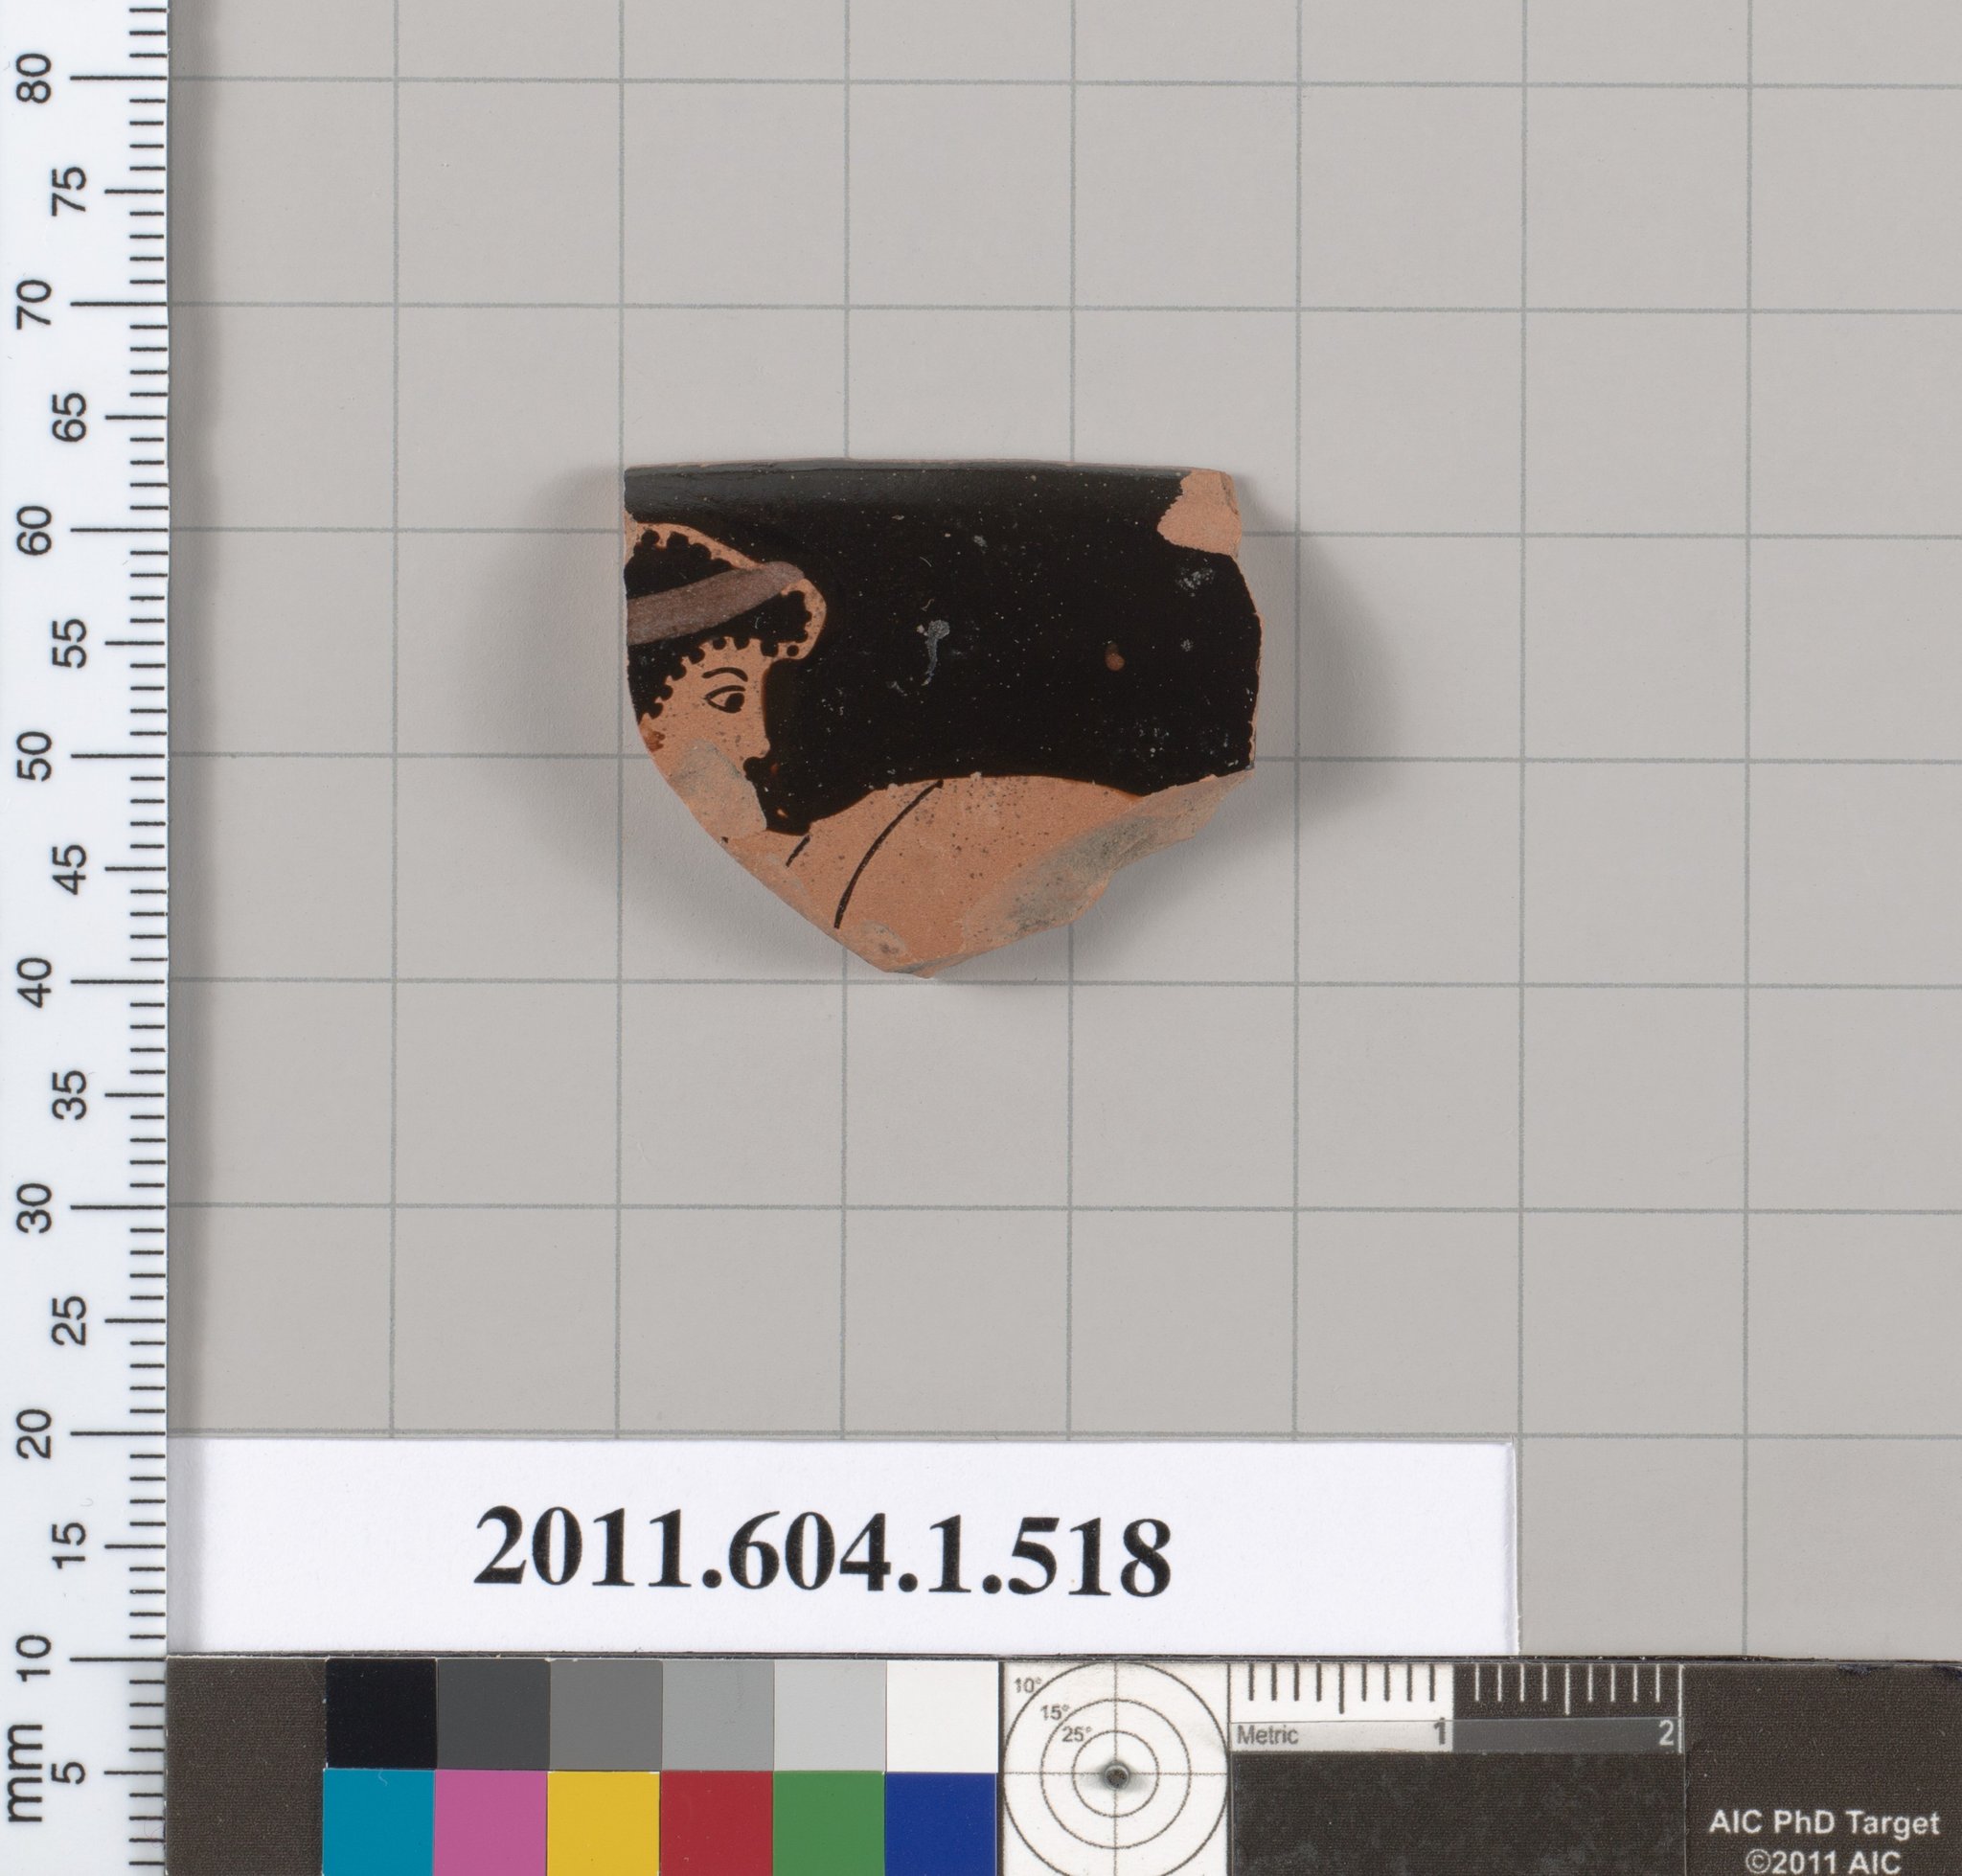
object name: kylix fragment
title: Terracotta rim fragment of a kylix (drinking cup)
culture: greek, attic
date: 490-480 BCE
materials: terracotta